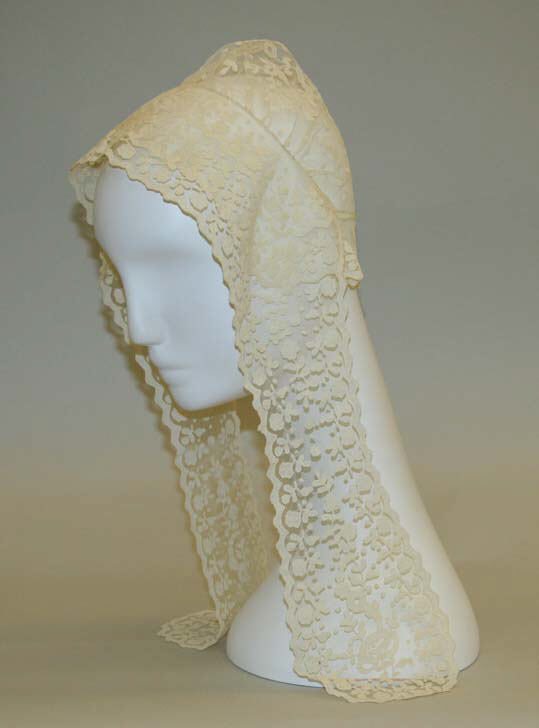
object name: morning cap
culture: irish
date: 1850-1860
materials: linen